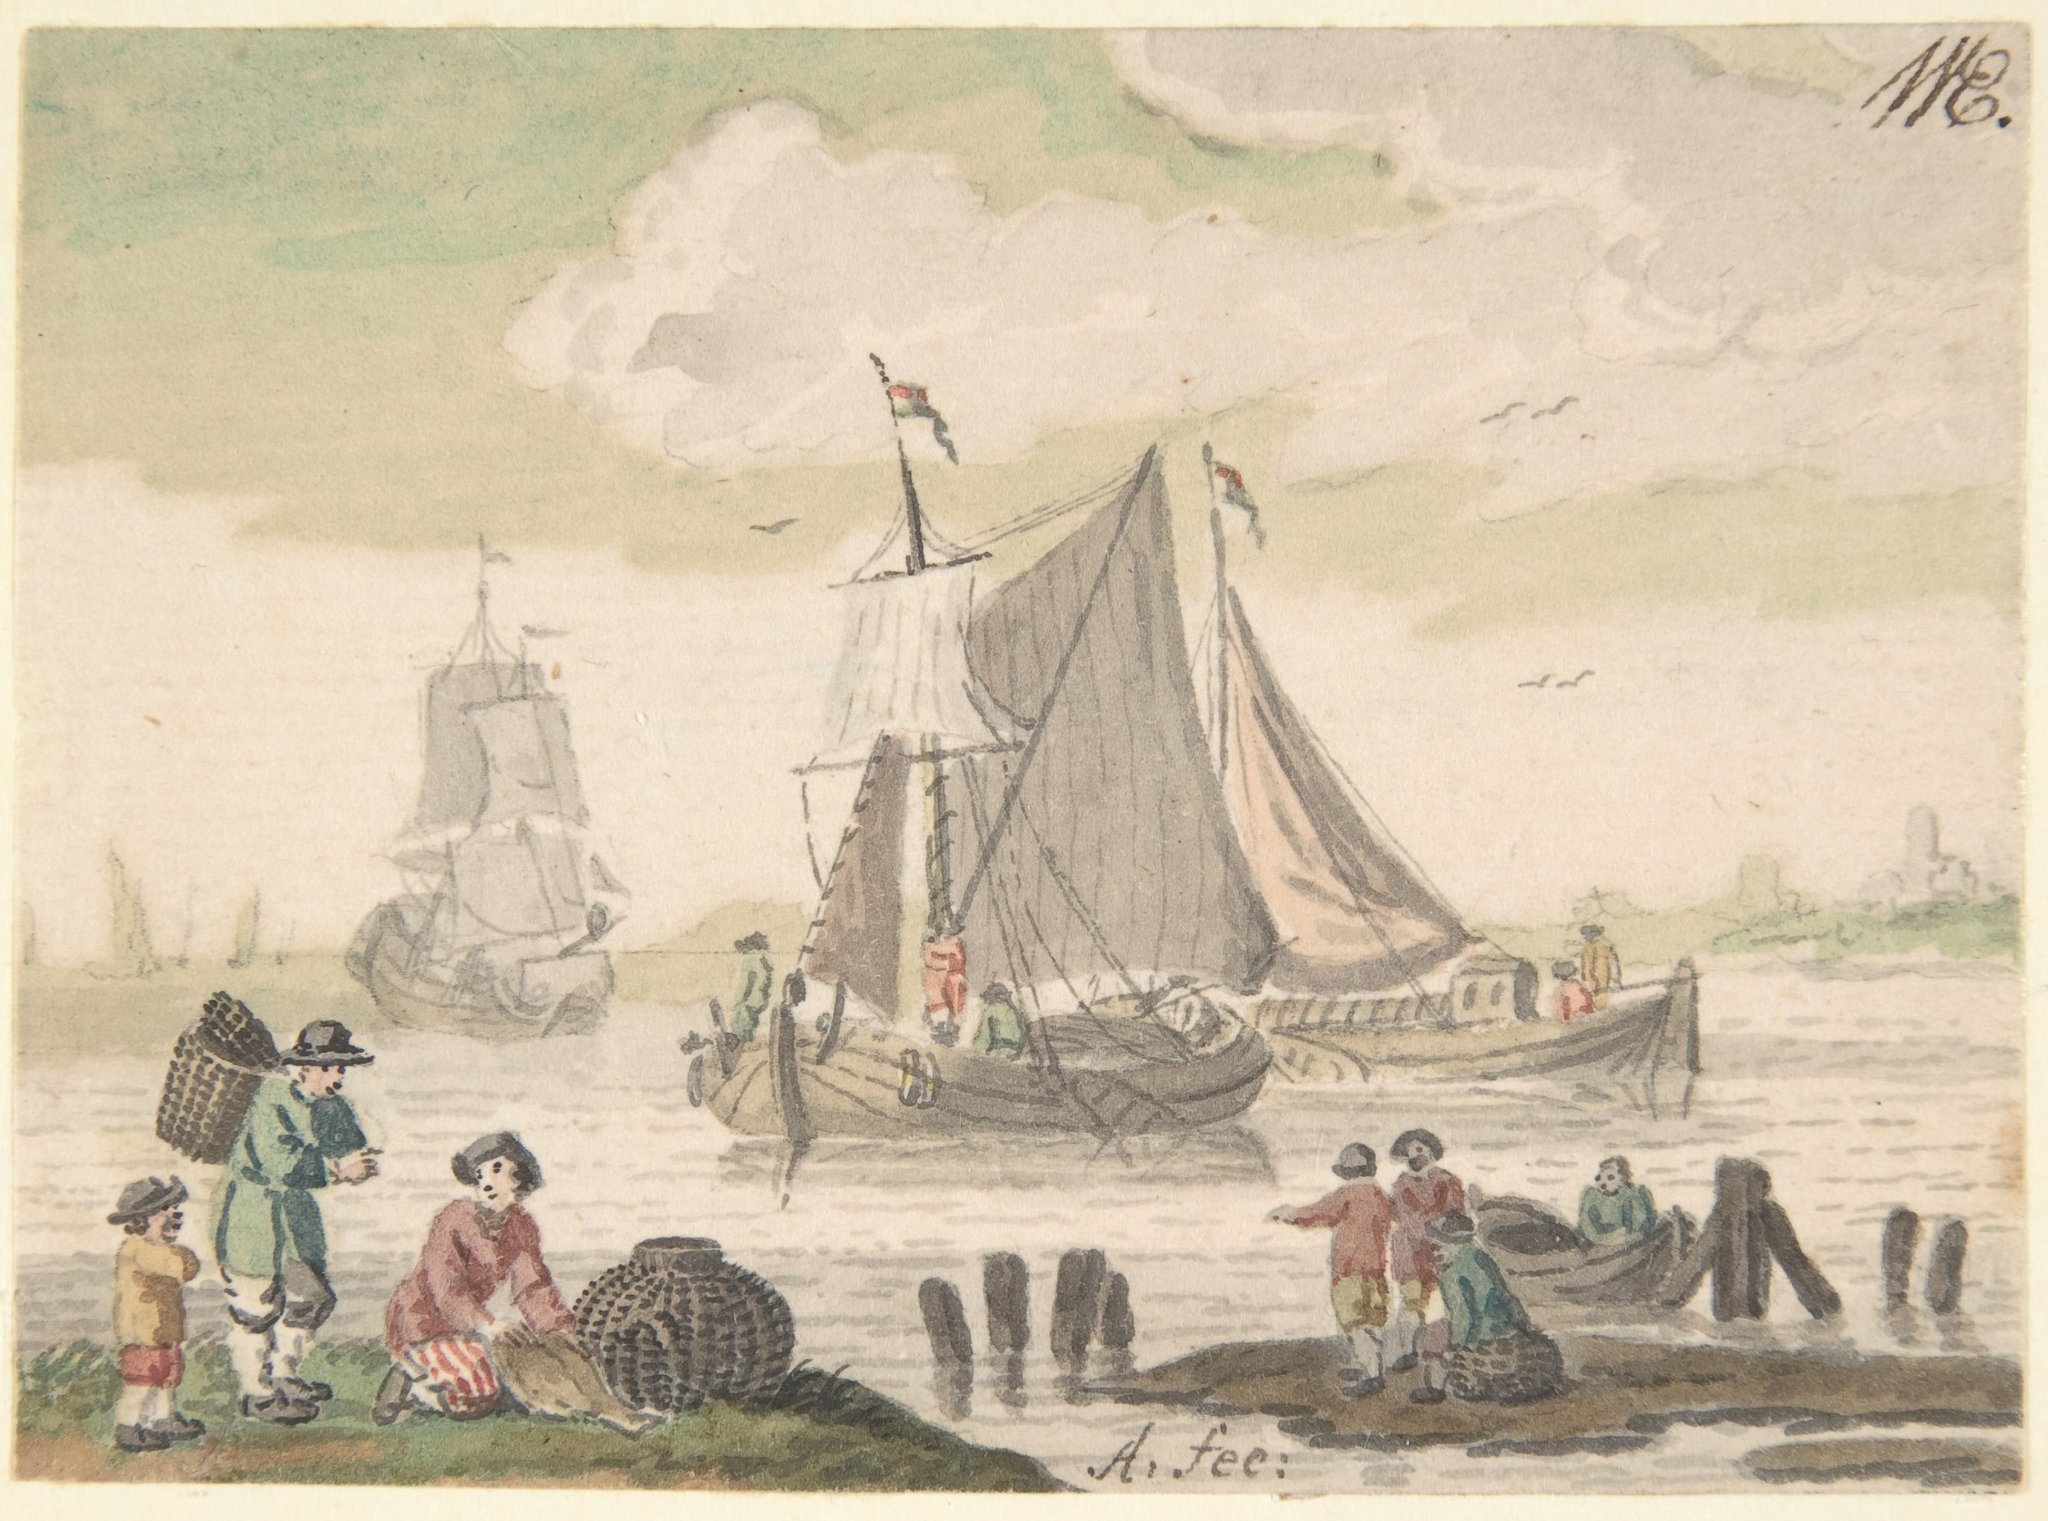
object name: drawing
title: Seascape with Six Figures in the Foreground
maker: nicolaas aartman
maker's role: artist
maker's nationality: dutch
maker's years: 1713-1793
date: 1728-1793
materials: chalk, ink, watercolor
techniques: brush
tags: birds,men,seascapes,flags,ships